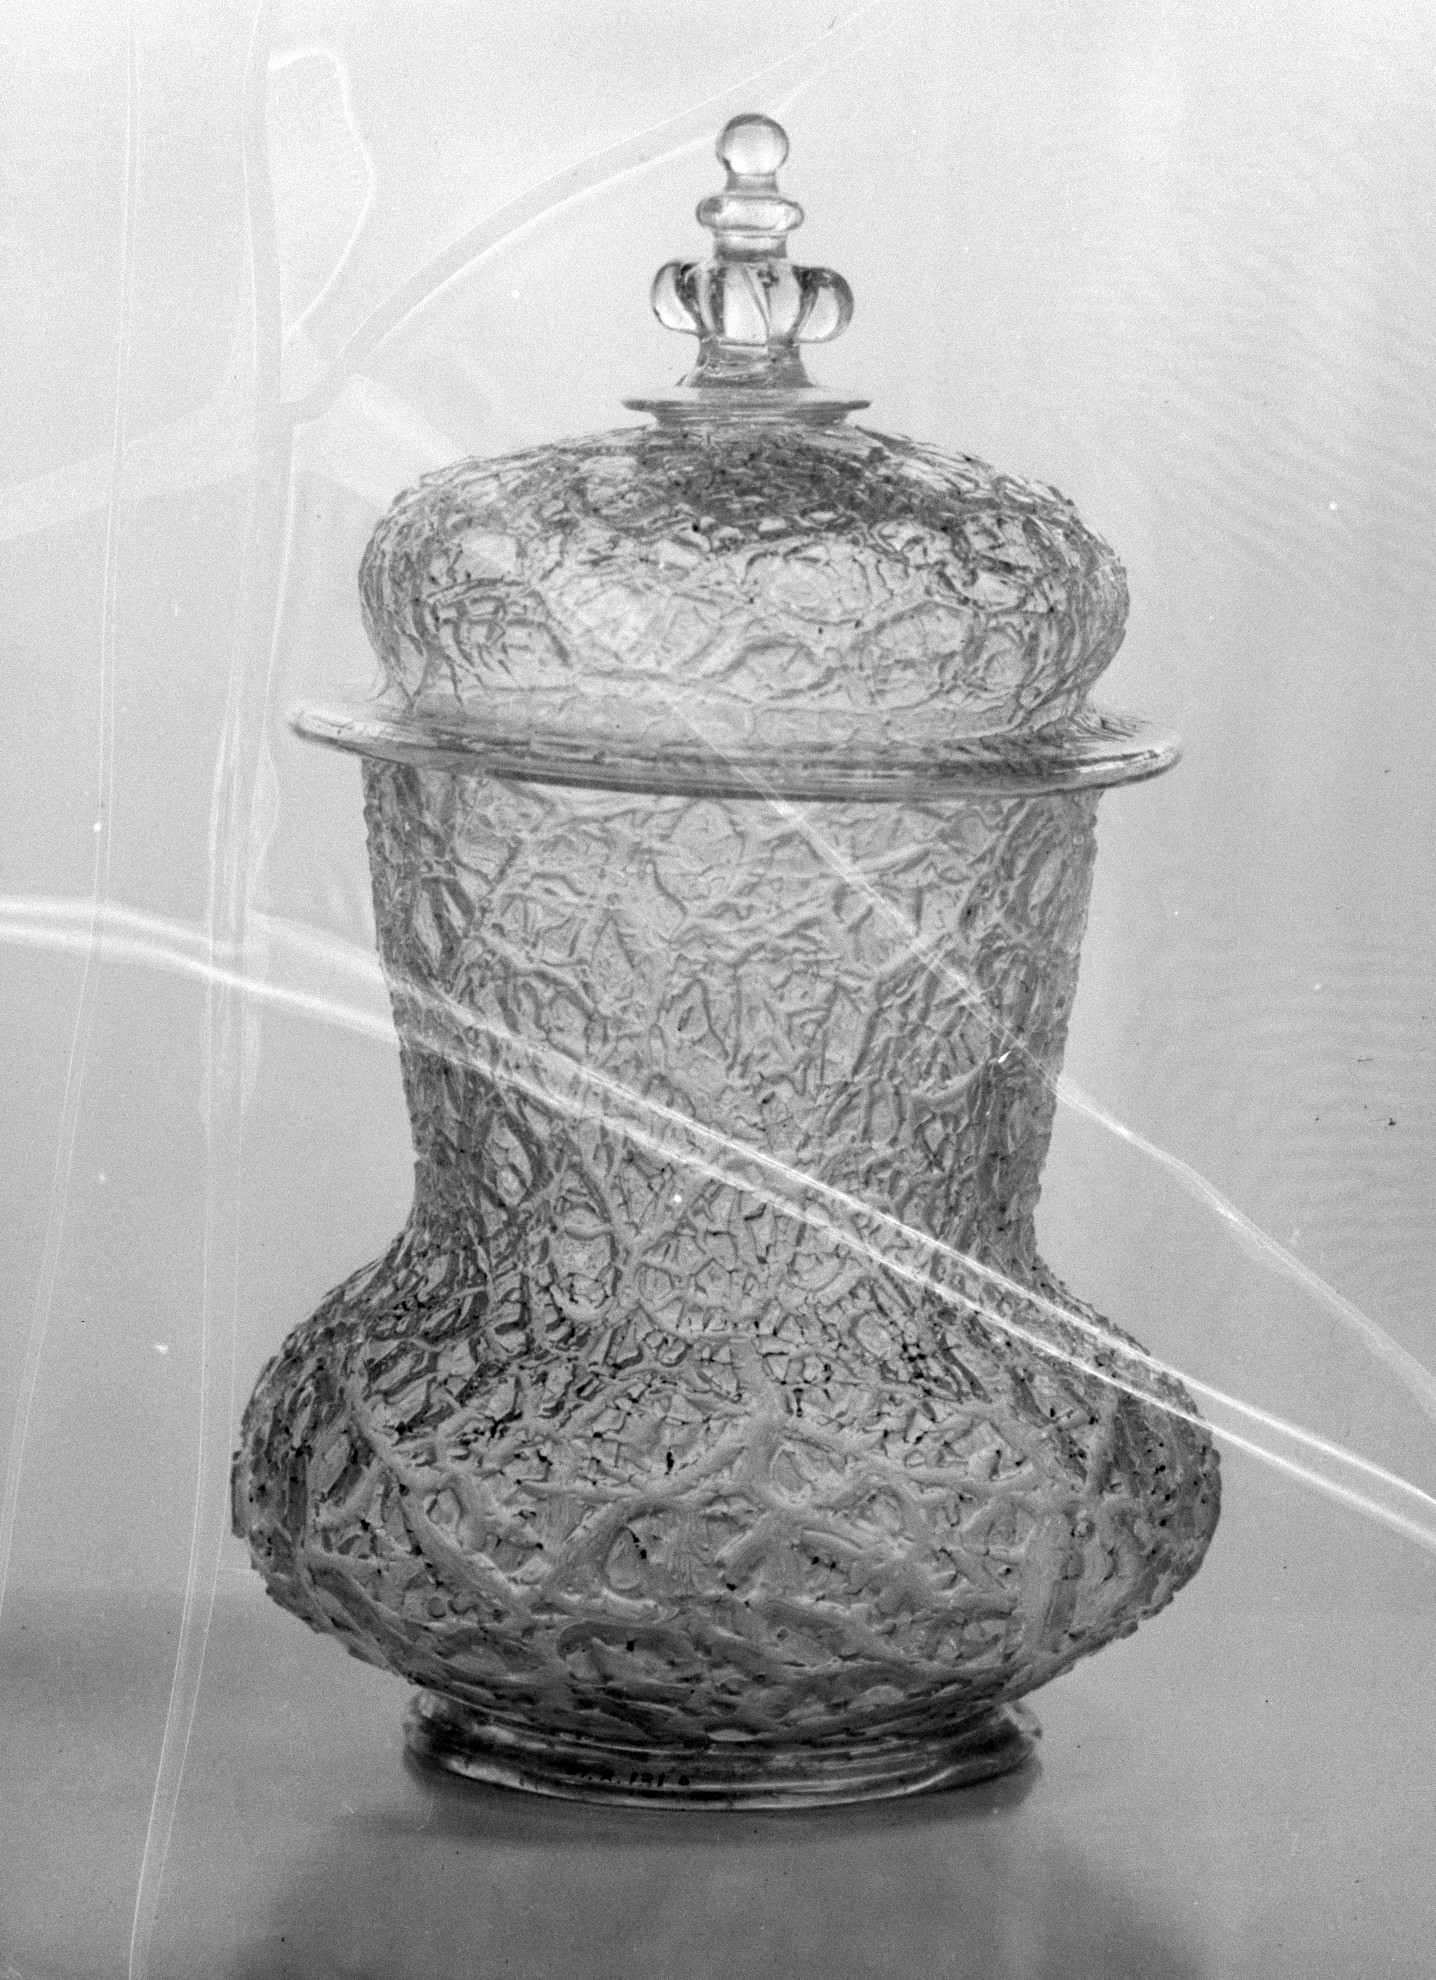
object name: jar with cover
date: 1651-1700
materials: glass